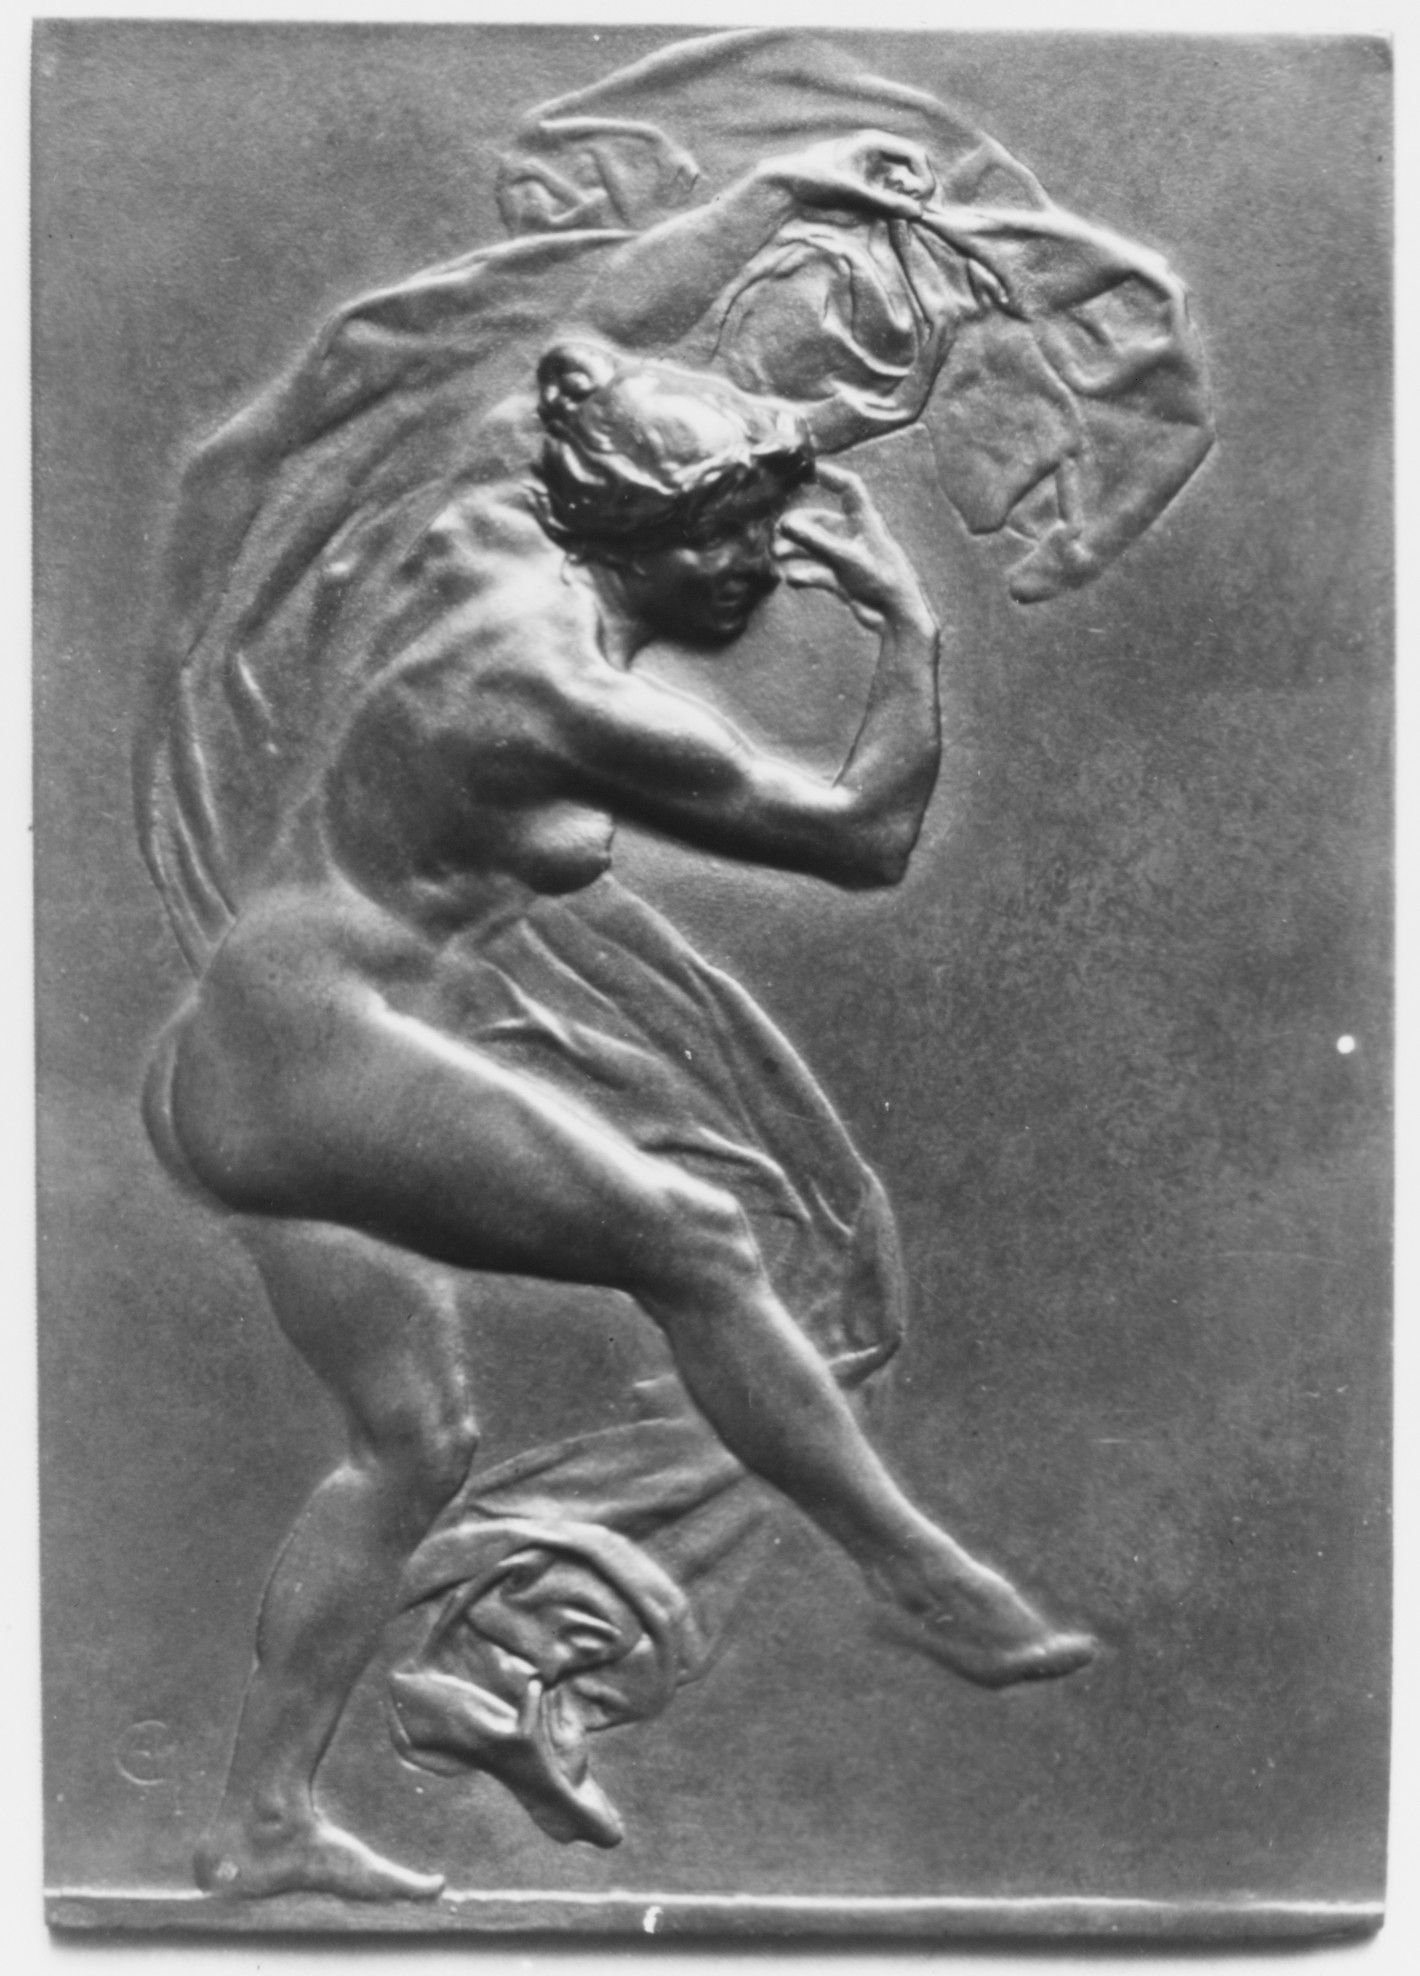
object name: plaquette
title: La Danse (one of a pair)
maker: alexandre-louis-marie charpentier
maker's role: artist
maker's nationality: french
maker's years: 1856-1909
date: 1903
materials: bronze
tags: female nudes